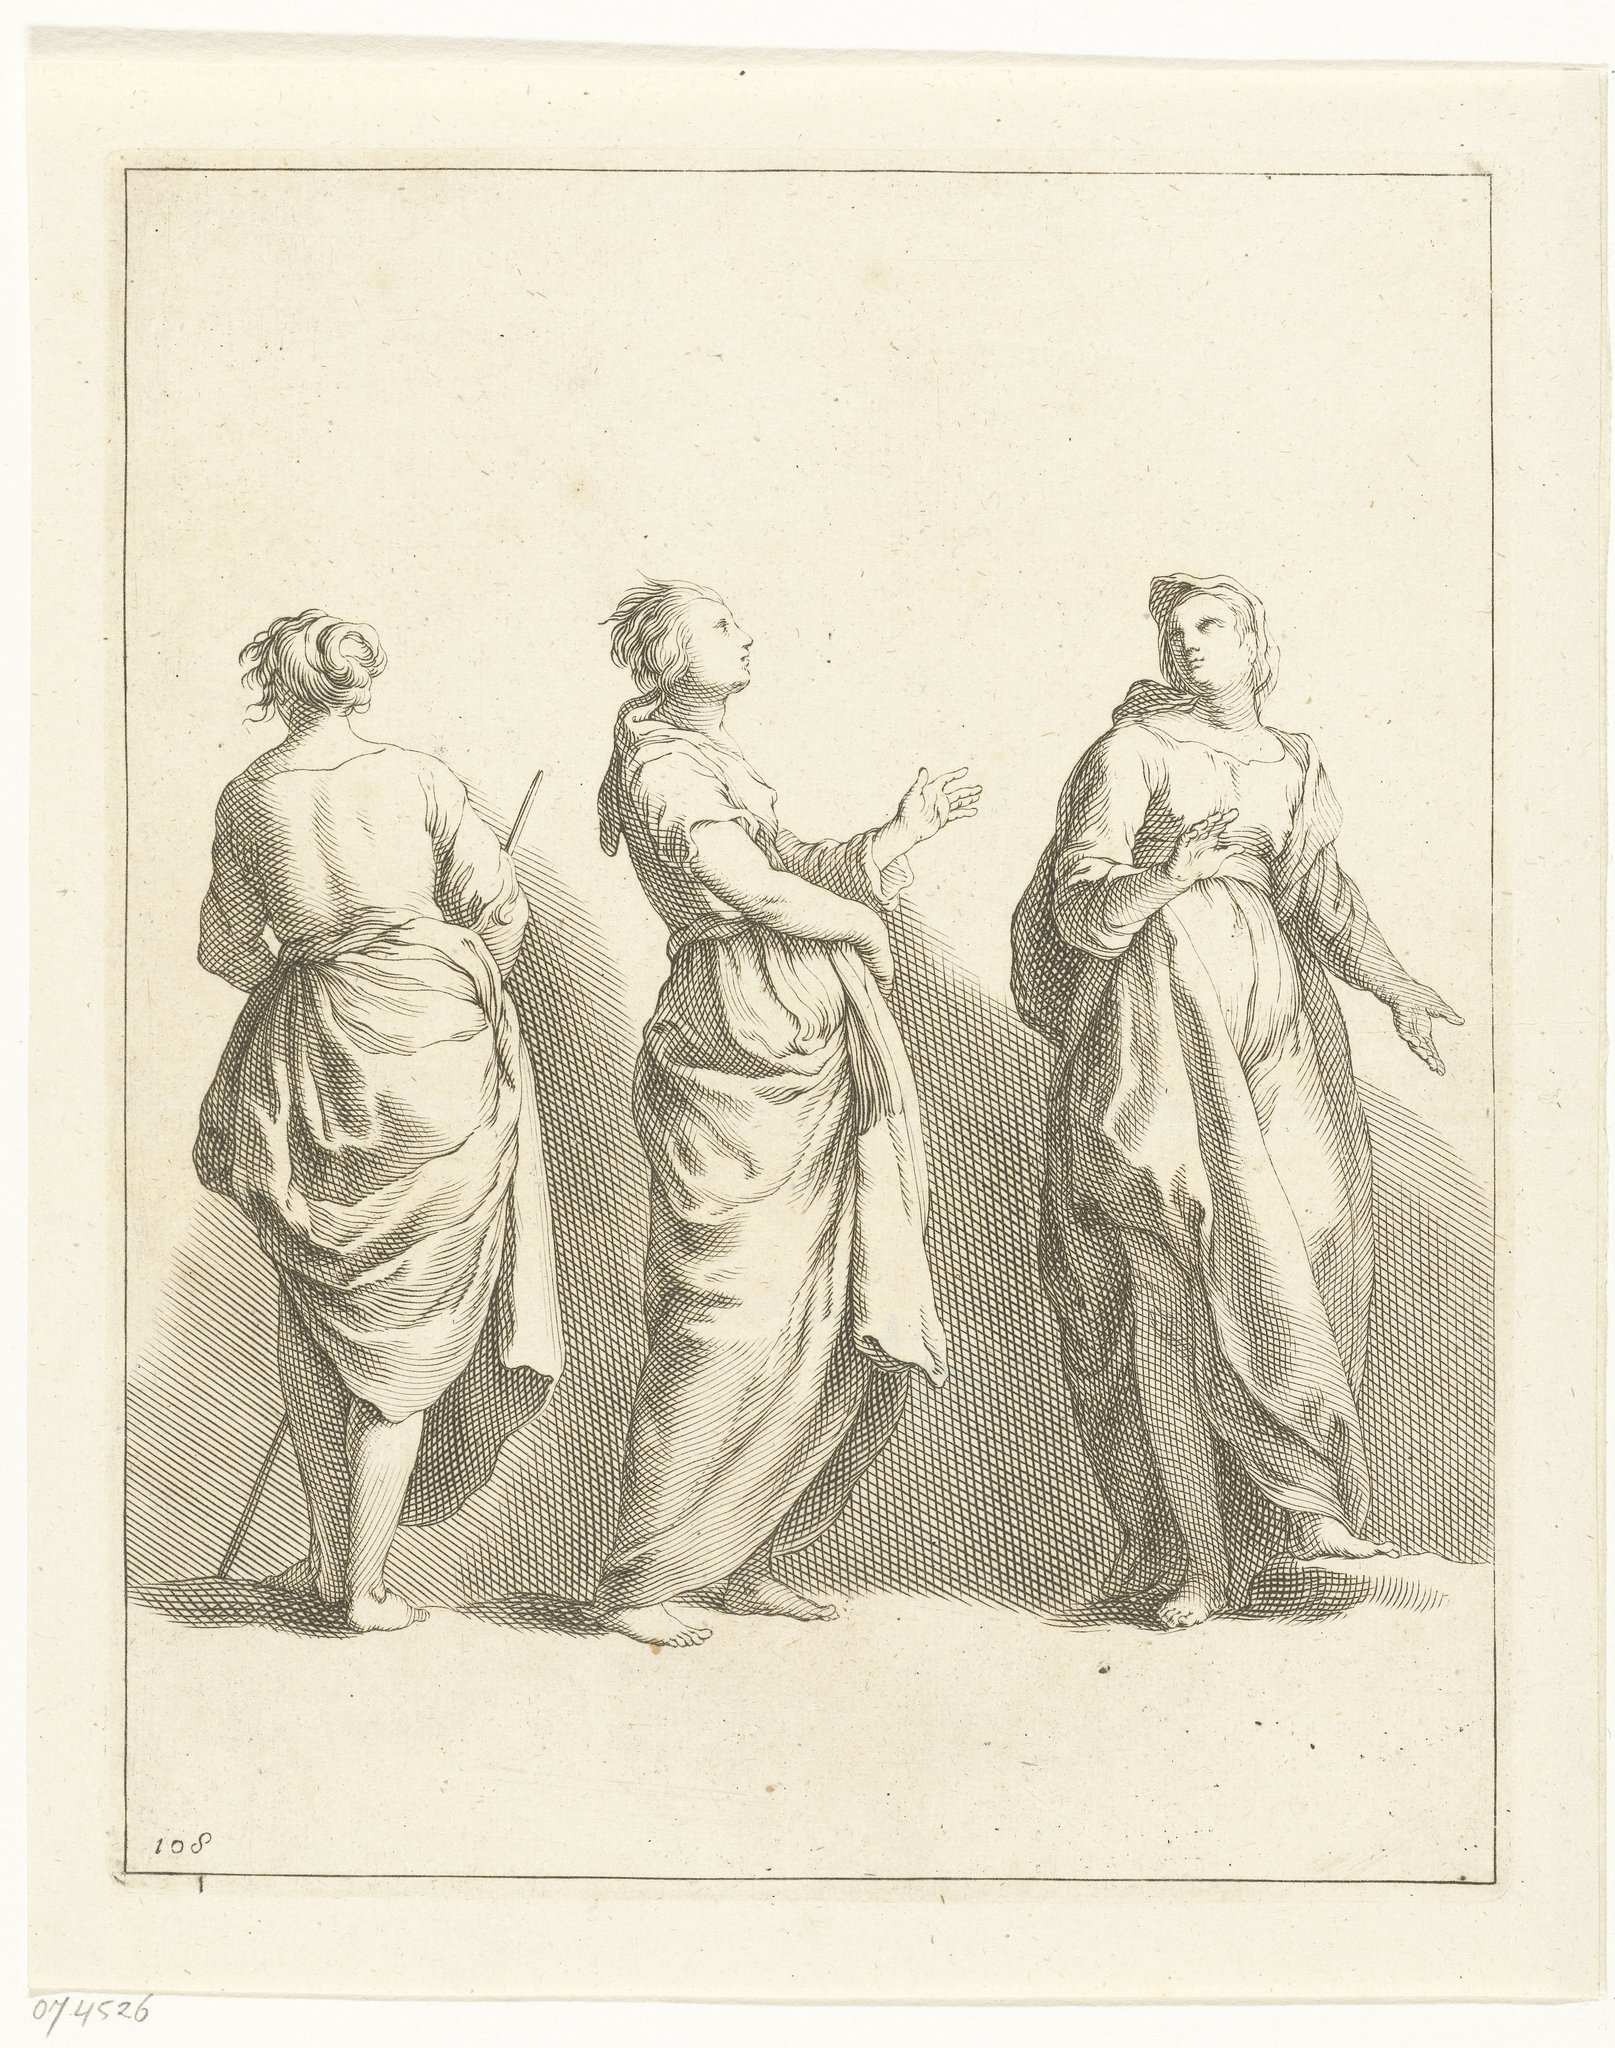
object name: print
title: Drie vrouwen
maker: frederick bloemaert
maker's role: print maker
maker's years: 1614-1669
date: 1650-1700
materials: paper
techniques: engraving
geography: utrecht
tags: human races; peoples; nationalities (+ women)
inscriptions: collector's mark: Lugt 2228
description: Drie geklede vrouwen: op de rug gezien, zijwaarts en vooraanzicht.